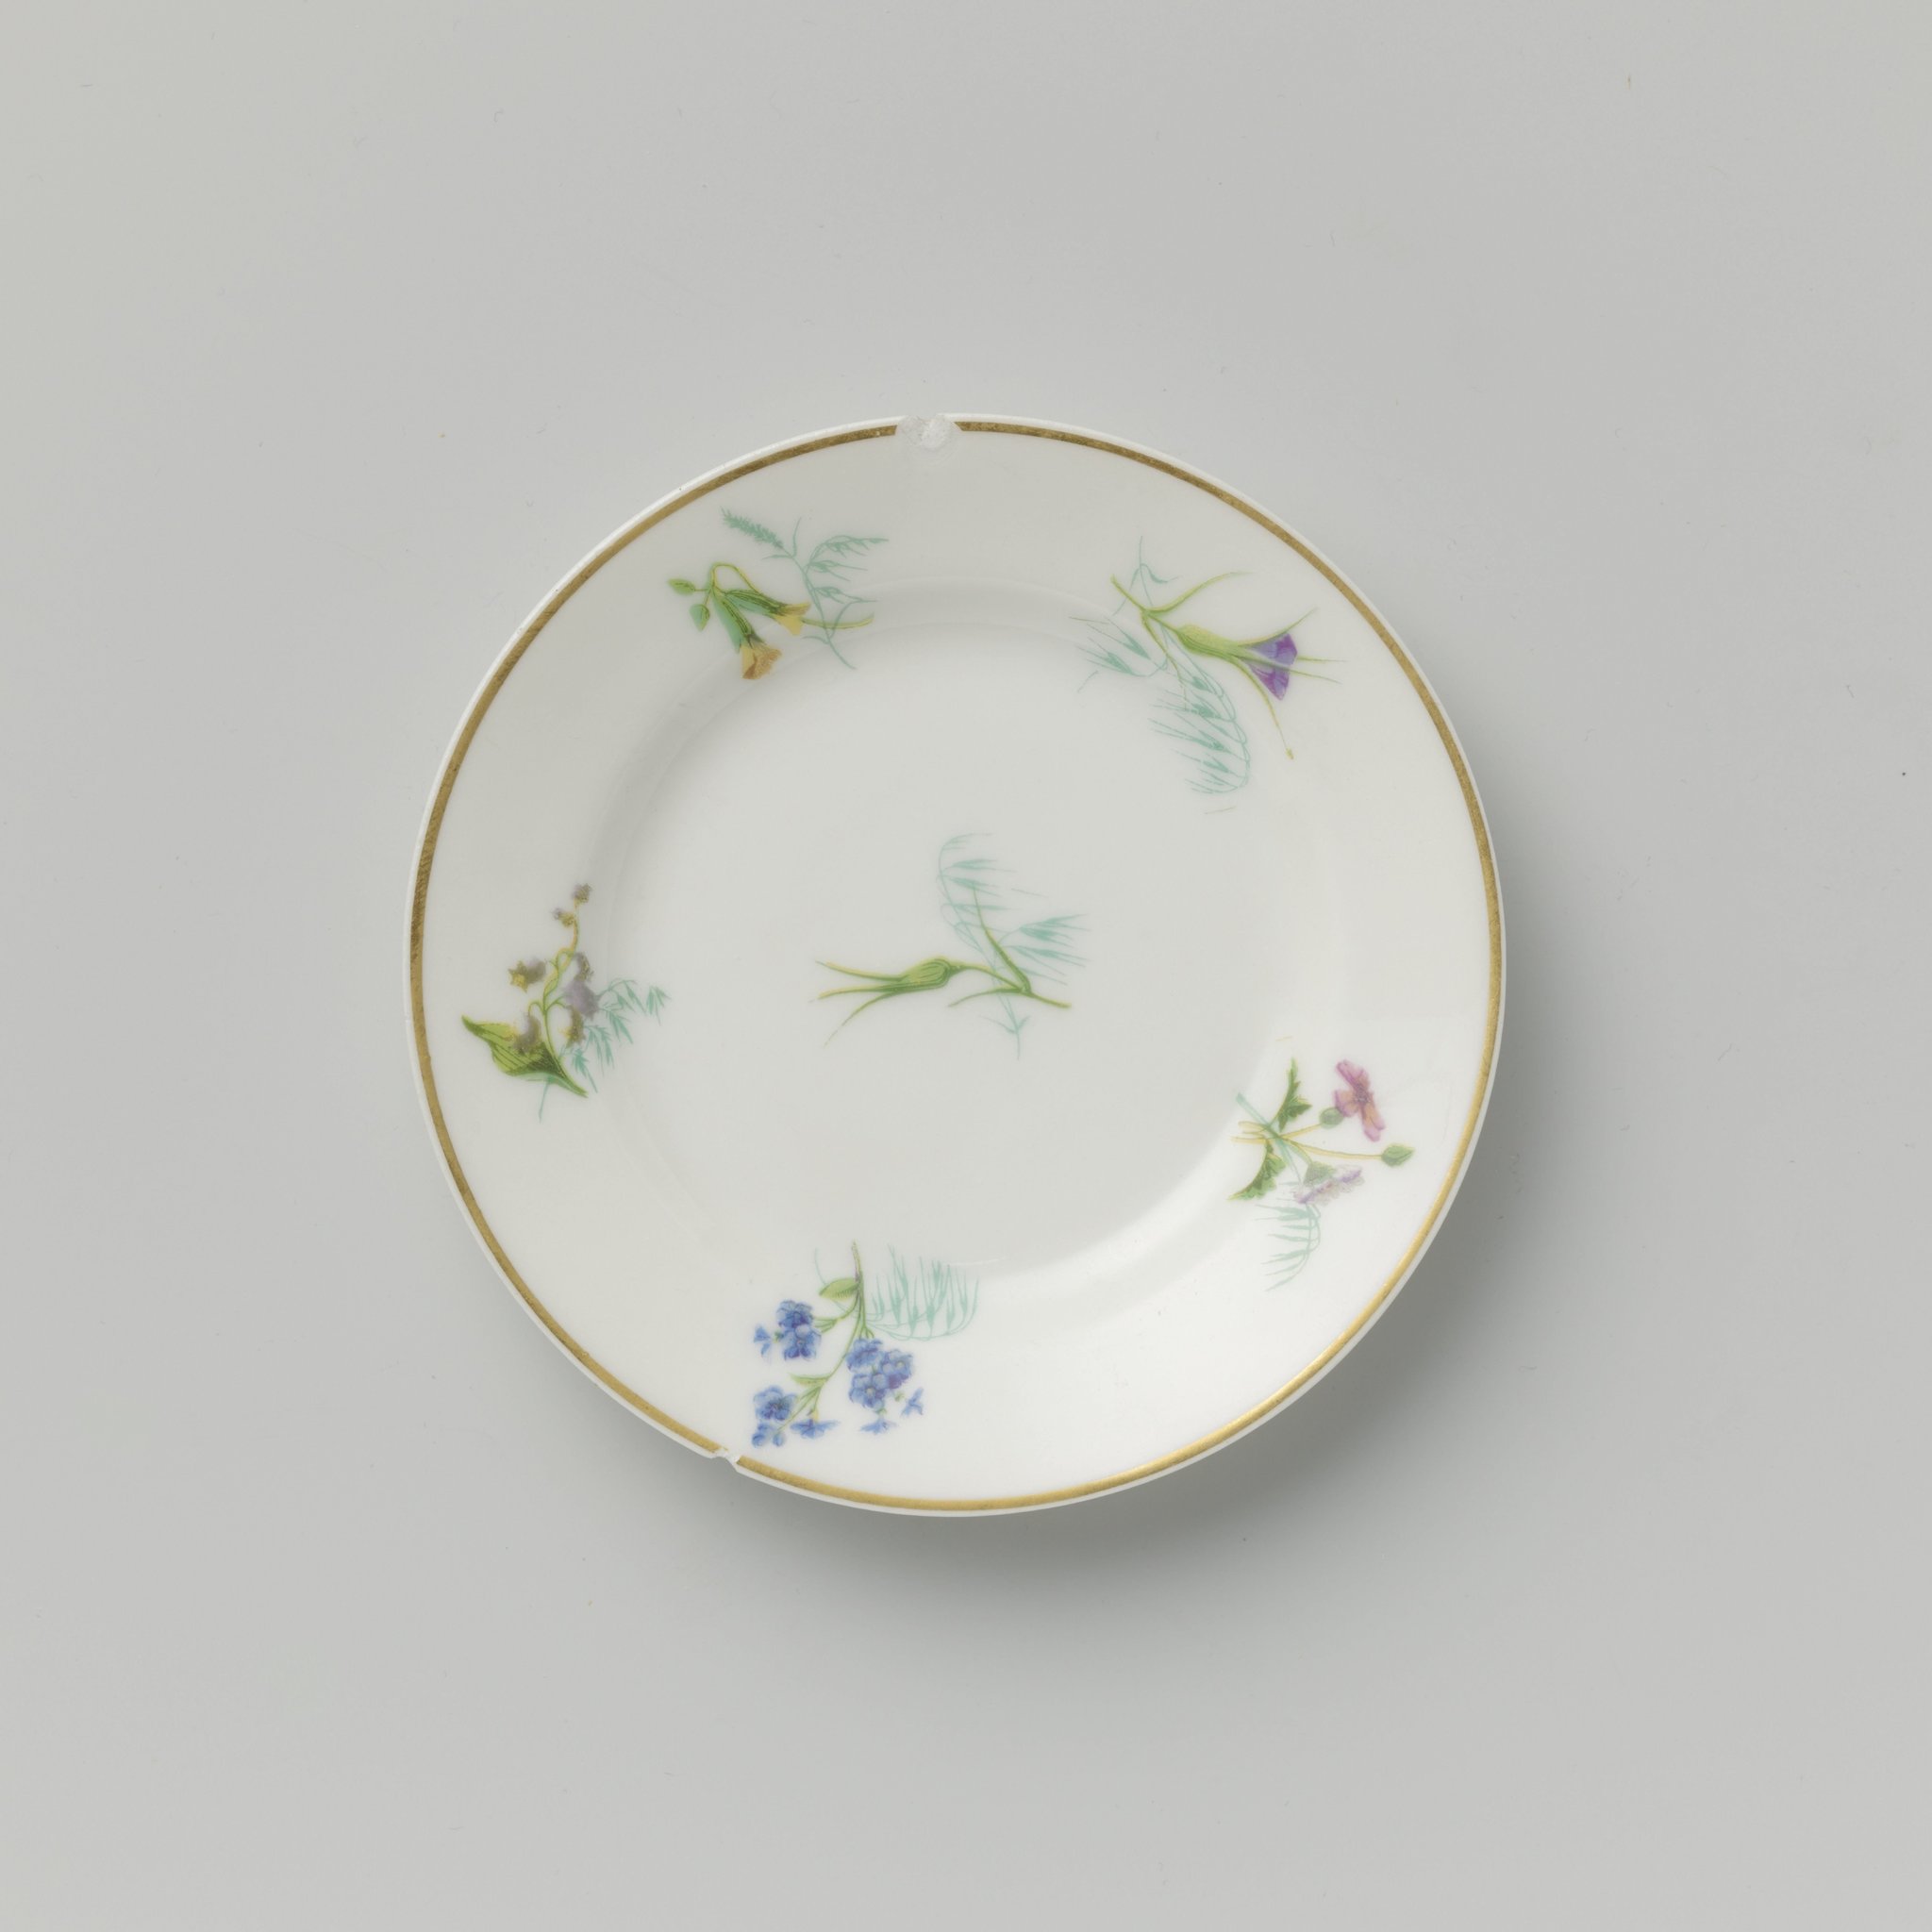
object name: kinderservies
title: Plate with various flower sprays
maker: Anonymous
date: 1850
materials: glaze, gold, paint, porcelain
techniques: firing, forming, gilding, turning, vitrification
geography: france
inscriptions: mark: ‘twee cijfers of letters?’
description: Bord van porselein, versierd op het glazuur met blauw, rood, roze, groen, geel, paars en goud. Op de voorzijde verschillende bloemtakken en een gouden lijn op de rand. Gemerkt op de onderzijde met twee onleesbare cijfers of letters.